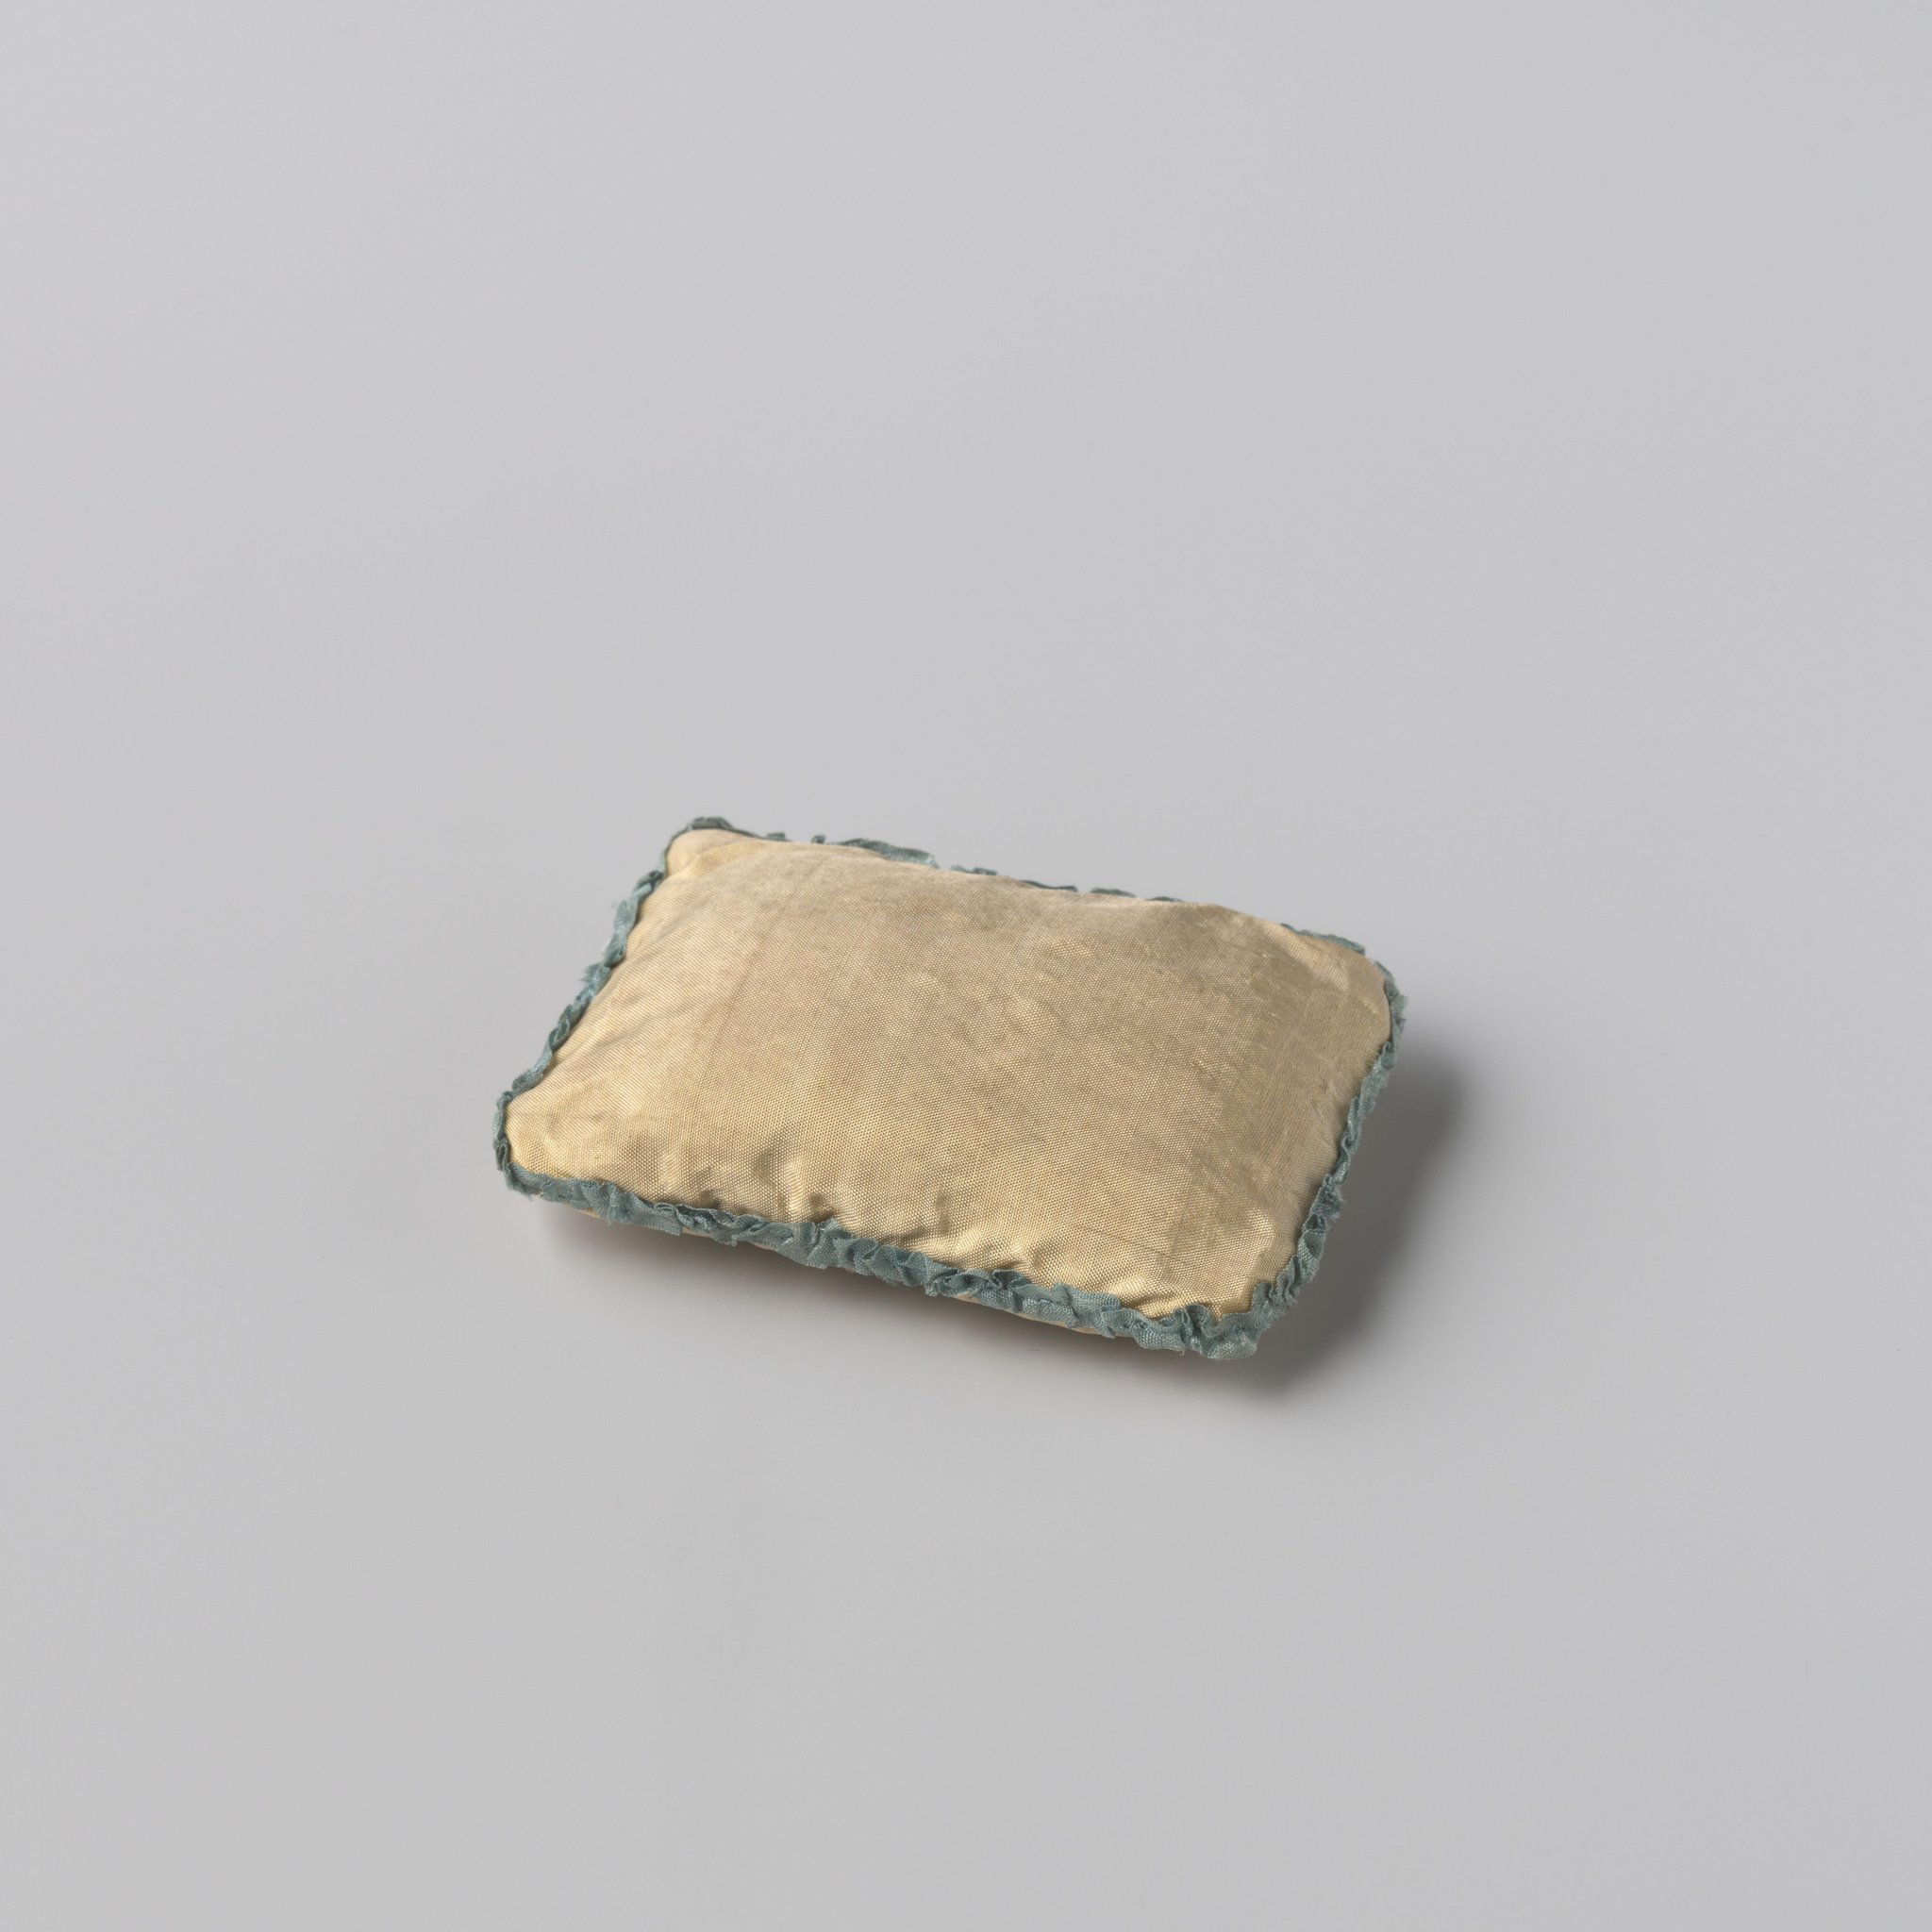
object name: miniature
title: Rechthoekig kussen vervaardigd van licht gele zijde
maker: Anonymous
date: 1690-1710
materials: down, silk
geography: amsterdam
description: Rechthoekige kussen vervaardigd van licht gele zijde, rondom afgezet met een ingerimpeld lintje van licht blauwe zijde. De kussens zijn gevuld met dons oorspronkelijk zonder tussenvoering.